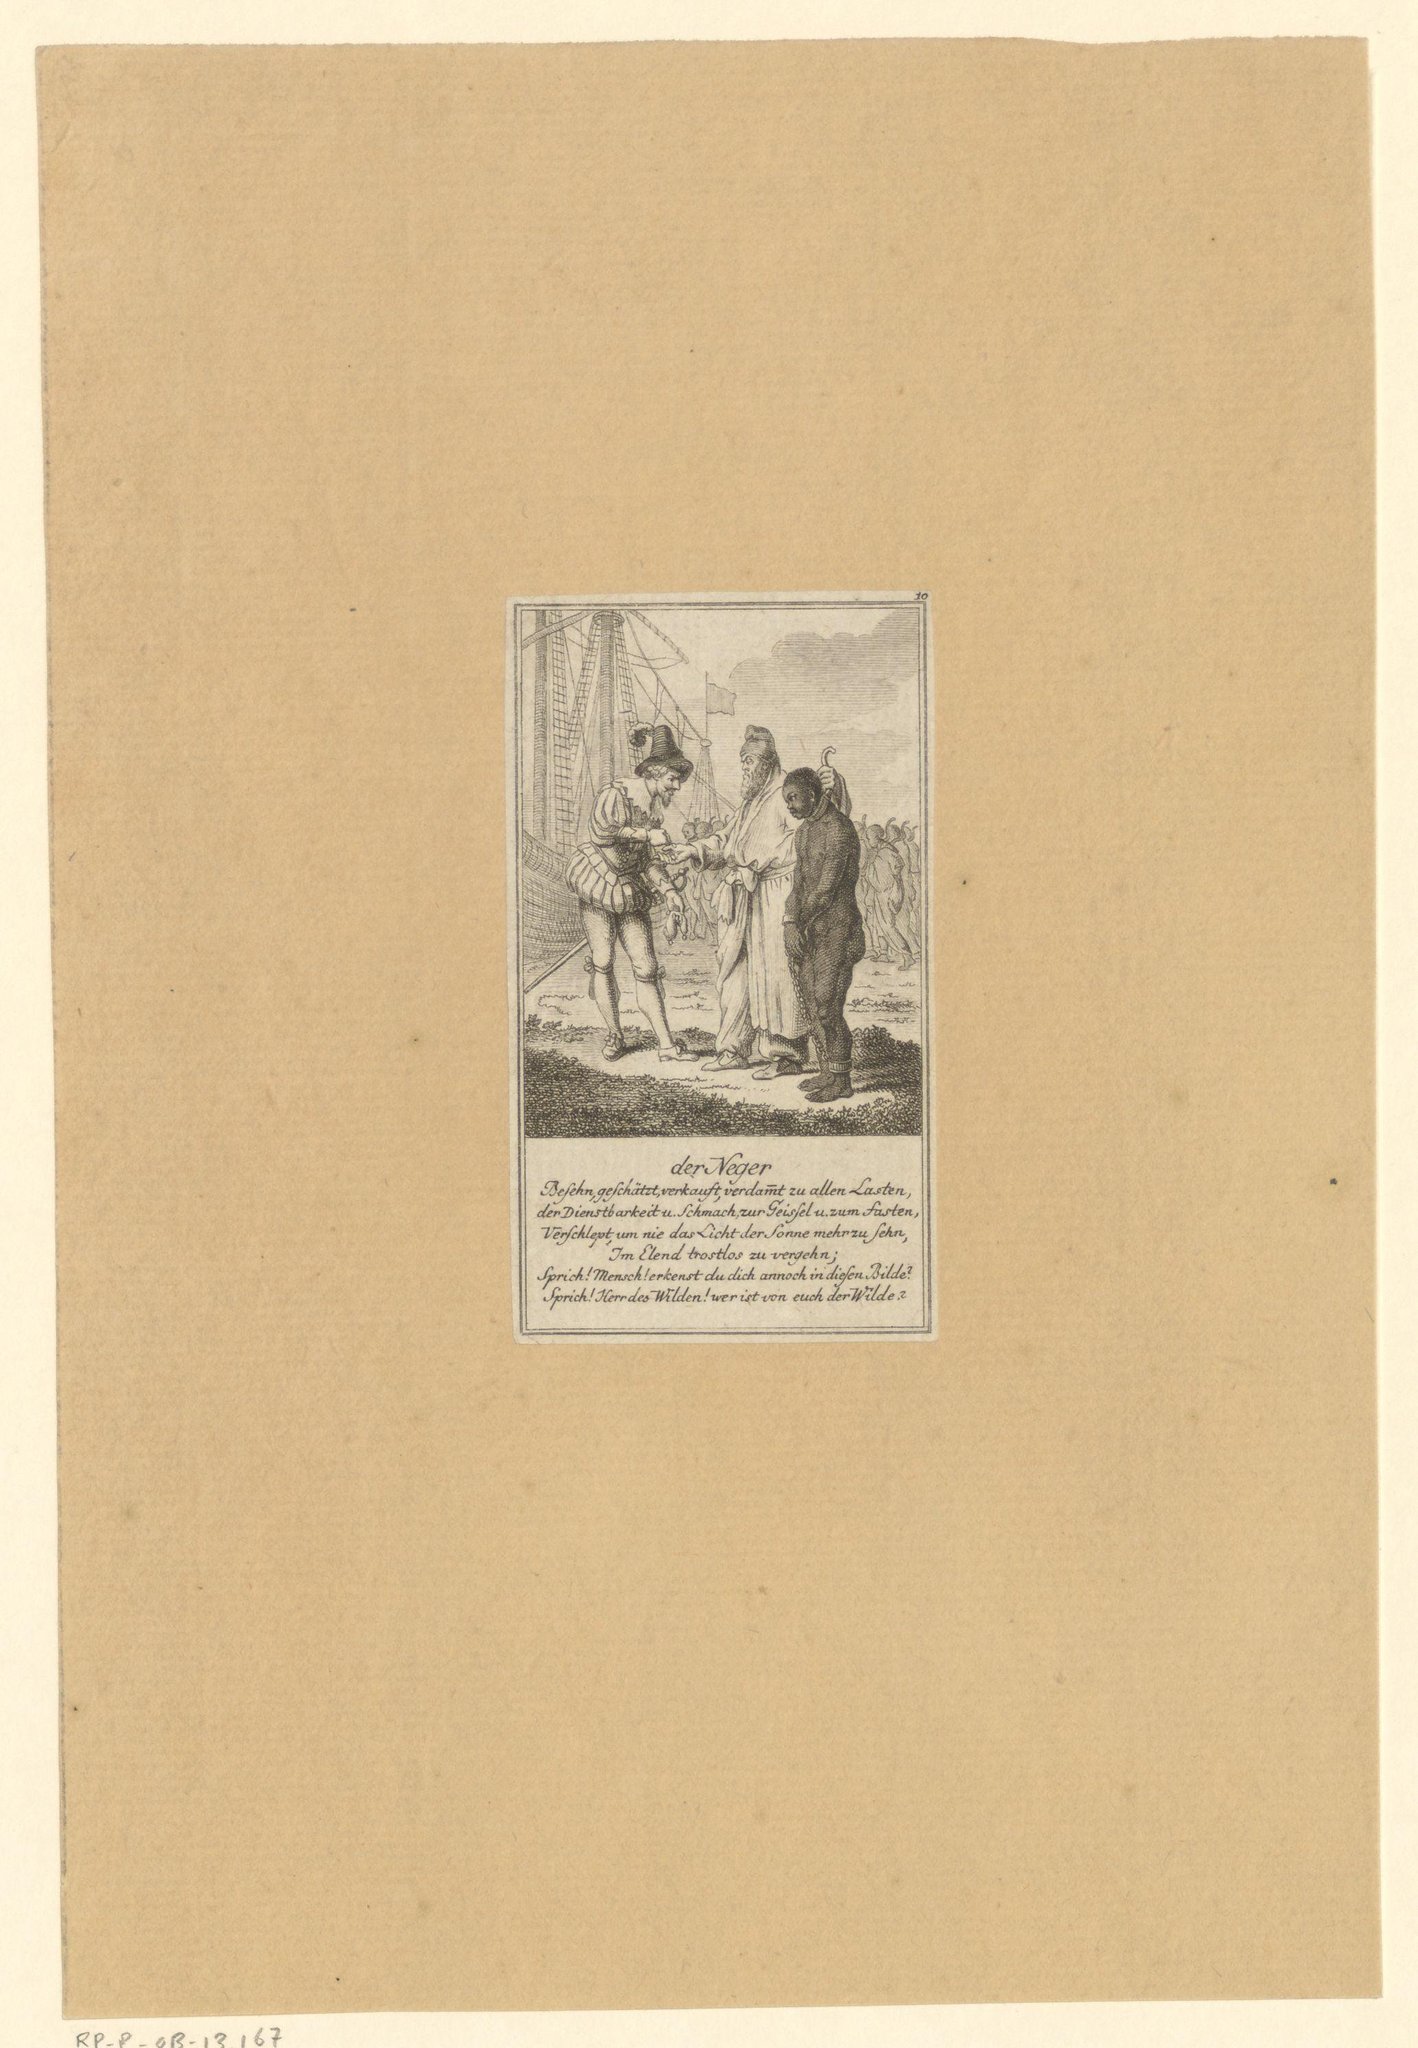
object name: book illustration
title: Slavenhandel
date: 1775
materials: paper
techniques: etching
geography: berlin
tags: master ~ enslaved person, slave-trade, africans, slavery; serfs and enslaved persons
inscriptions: collector's mark: Lugt 2228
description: Een slavenhandelaar verkoopt een tot slaaf gemaakte Afrikaanse man aan een Europese man. De koper houdt een zak geld in zijn hand. Op de achtergrond gaan meer tot slaaf gemaakte mannen aan boord van een schip. De mannen en vrouwen zijn om de nek geboeid met een haak. Rechtsboven genummerd: 10.